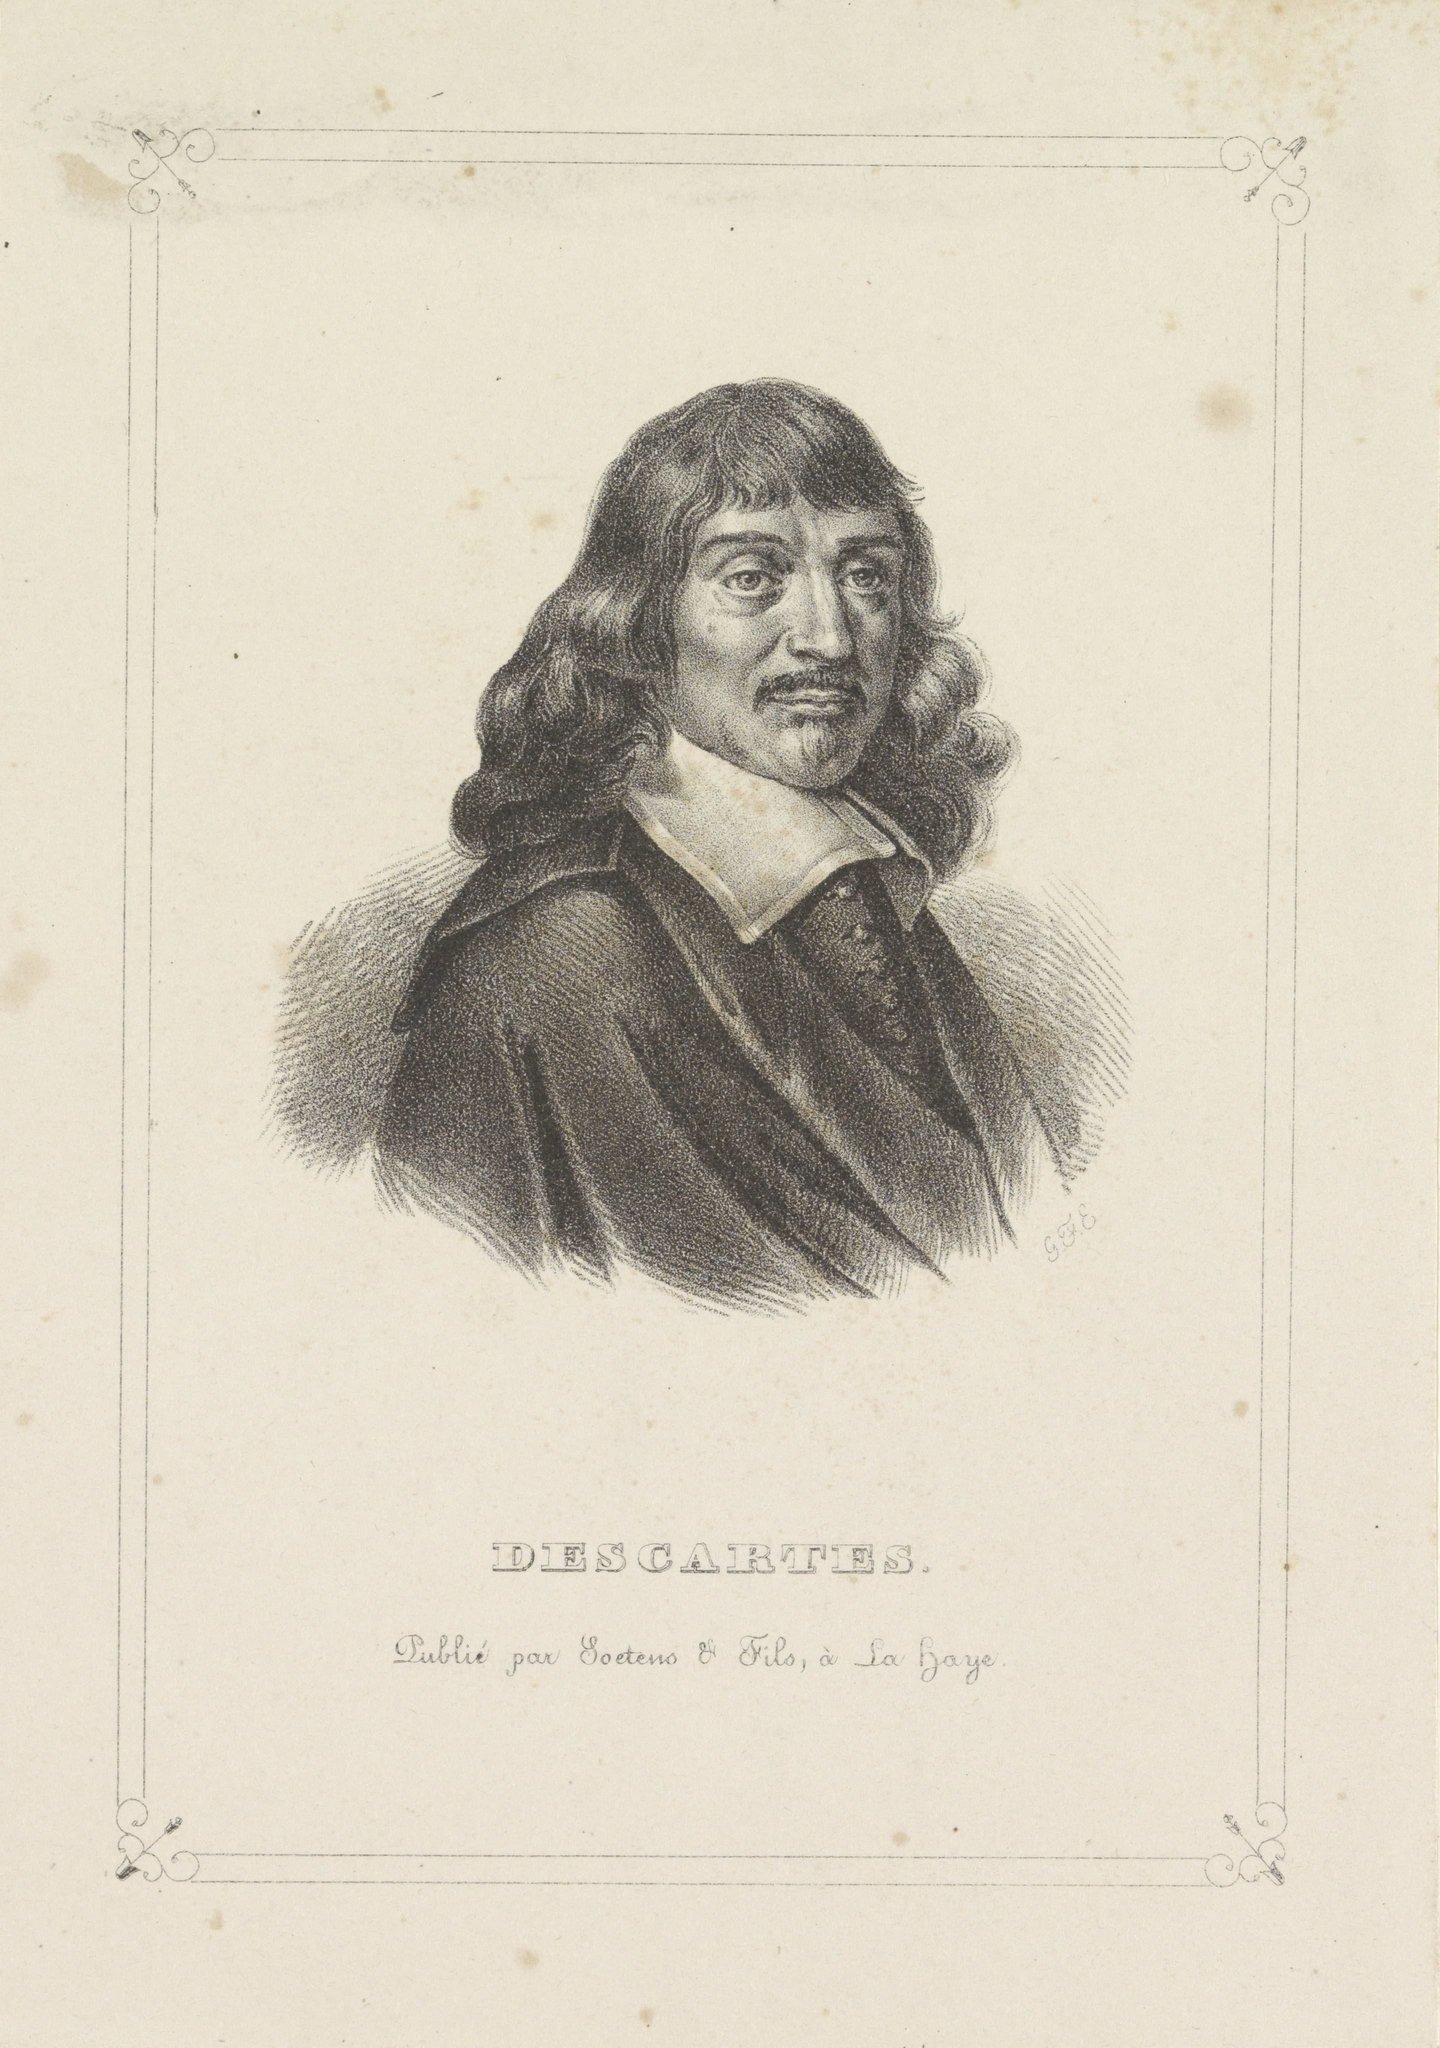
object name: print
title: Serie portretten door Soetens & Fils uit 1838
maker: gerhardus fredericus eilbracht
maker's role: draughtsman, print maker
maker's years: 1816-1854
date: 1837-1840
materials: paper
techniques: lithograph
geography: the hague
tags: rené descartes, historical persons (+ (full) bust portrait)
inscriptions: collector's mark: Lugt 2228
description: Deze prent maakte deel uit van een serie uitgegeven door Soetens et Fils omstreeks 1838, opgedragen aan de Prins van Oranje. In de 'Prospectus en Inteekenlijst' stond vermeld dat het zal bestaan uit een onbepaald aantal portretten, waarvan er drie of vier per maand verschijnen. Zie Van Someren.